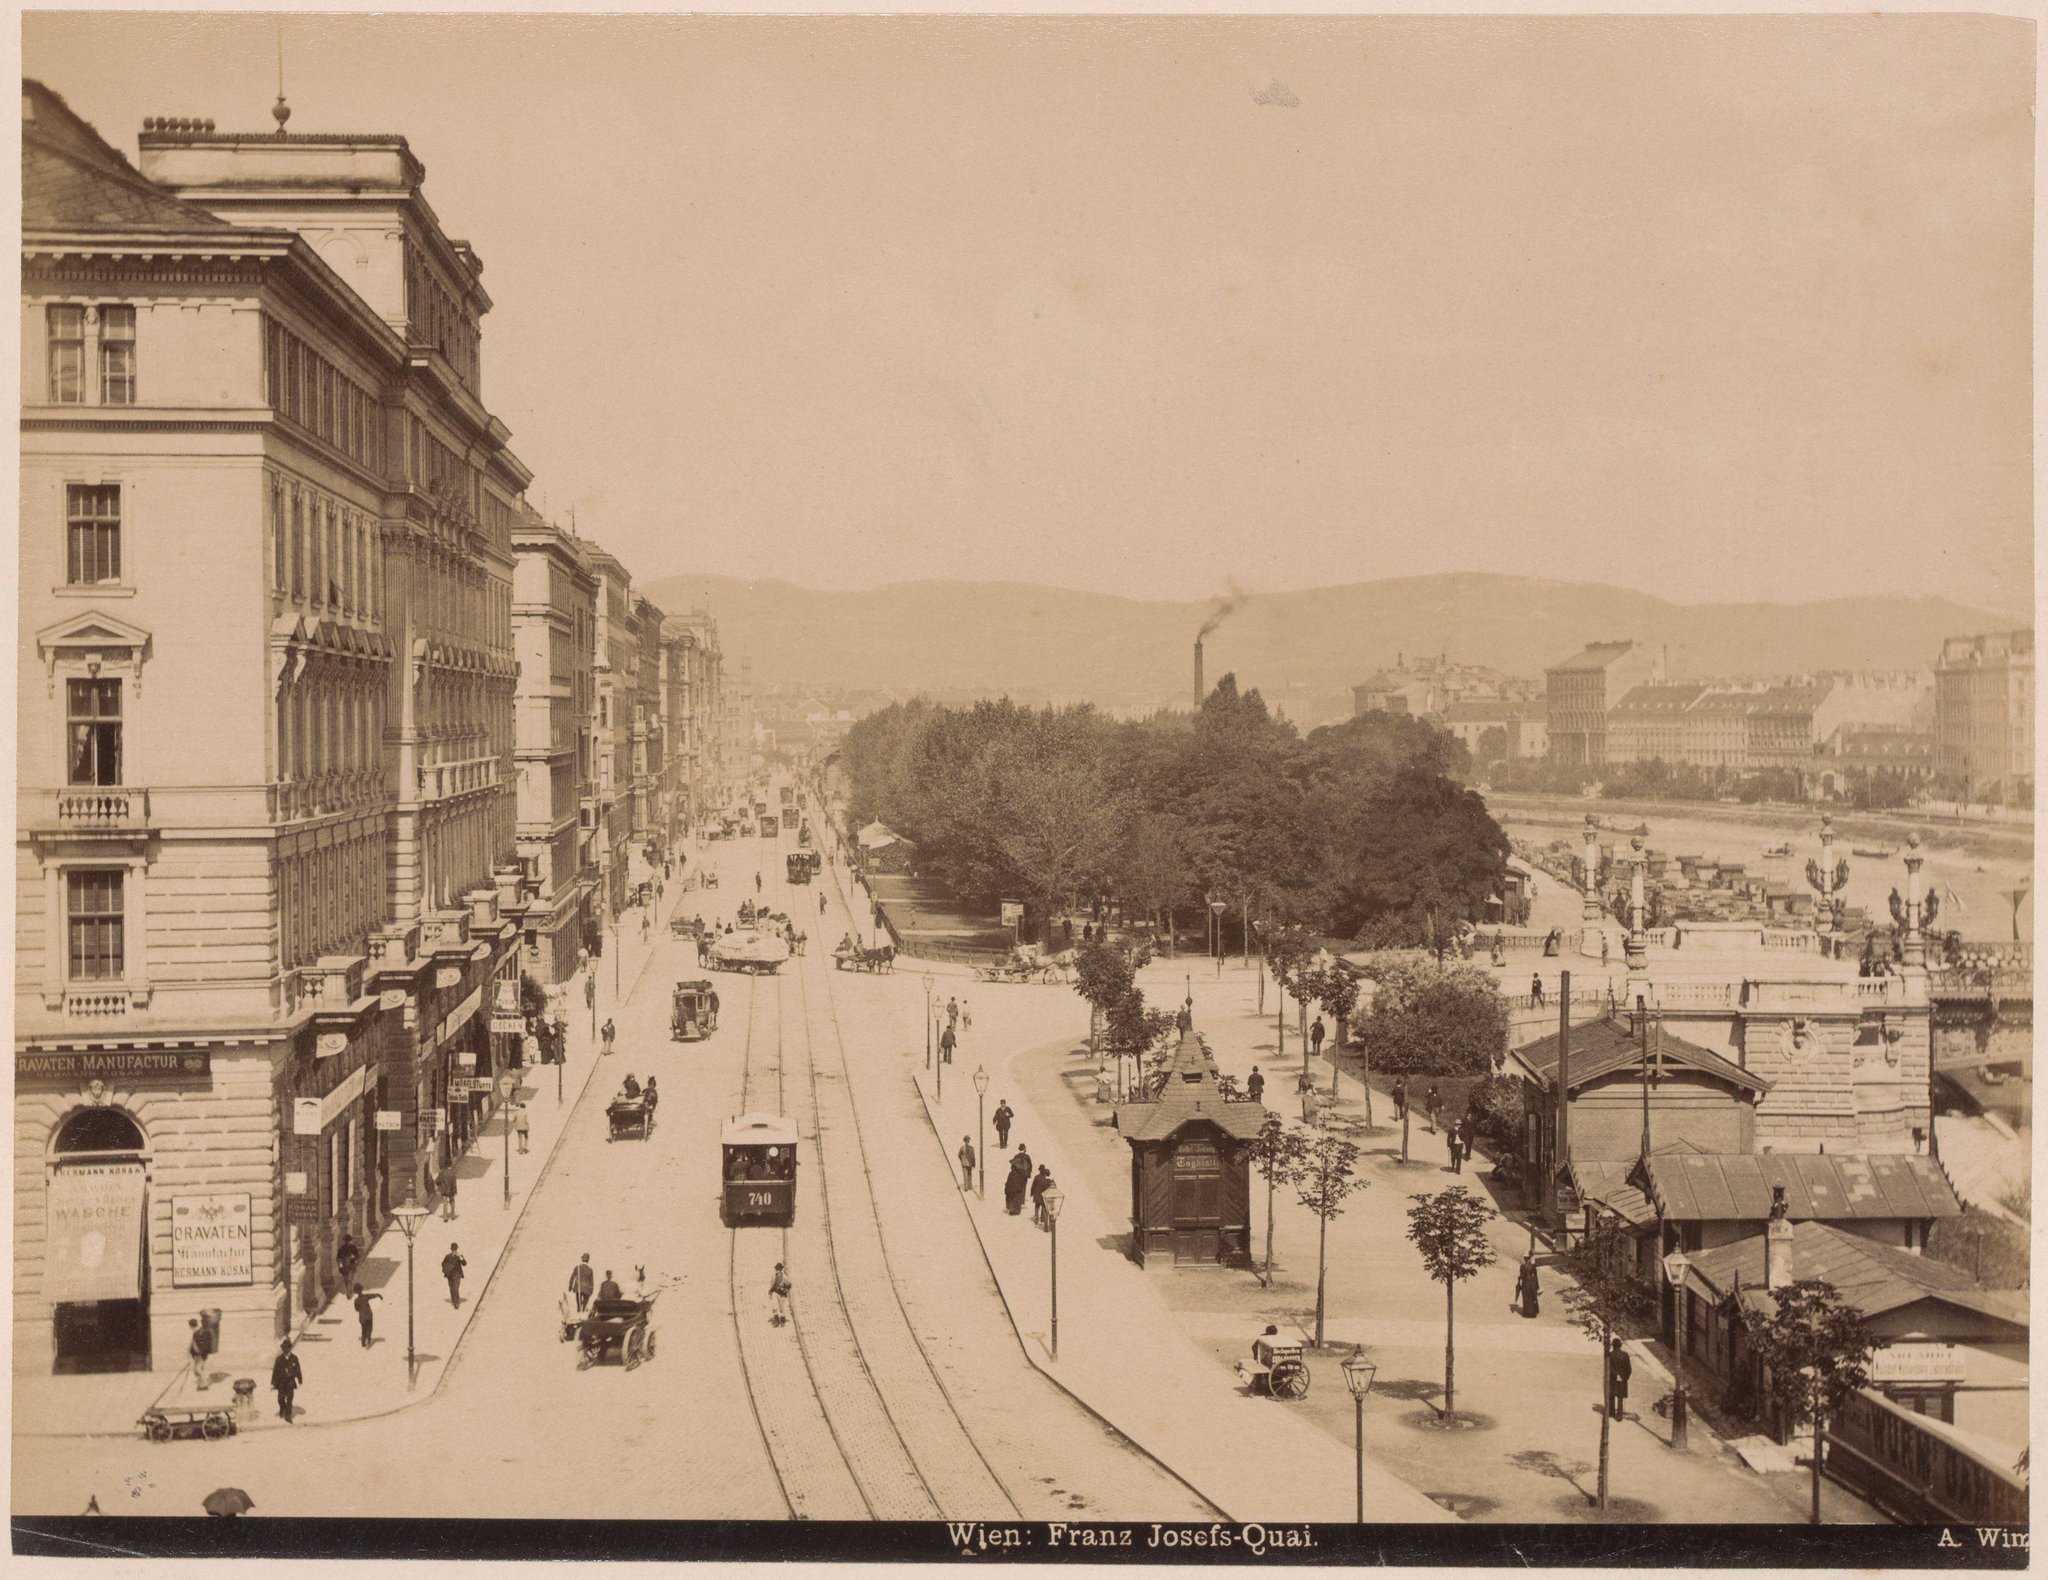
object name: photograph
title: Wien. Franz Josefs-Quai.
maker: a. wimmer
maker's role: fotograaf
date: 1880-1895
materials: paper, photographic support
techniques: albumen print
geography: vienna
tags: shop, store, tramway, tram, four-wheeled, animal-drawn vehicle, e.g.: cab, carriage, coach, pier, quay, wharf, street (+ city(-scape) with figures, staffage), vienna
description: Onderdeel van Reisalbum met foto's van bezienswaardigheden in Duitsland en Oostenrijk en van kunstwerken.